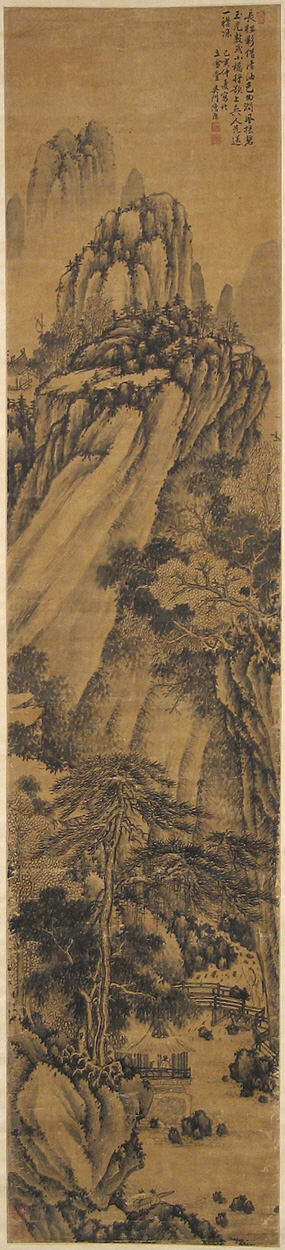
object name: hanging scroll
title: Landscape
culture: chinese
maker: monk jie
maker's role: artist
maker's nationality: chinese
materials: ink, textile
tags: mountains,landscapes